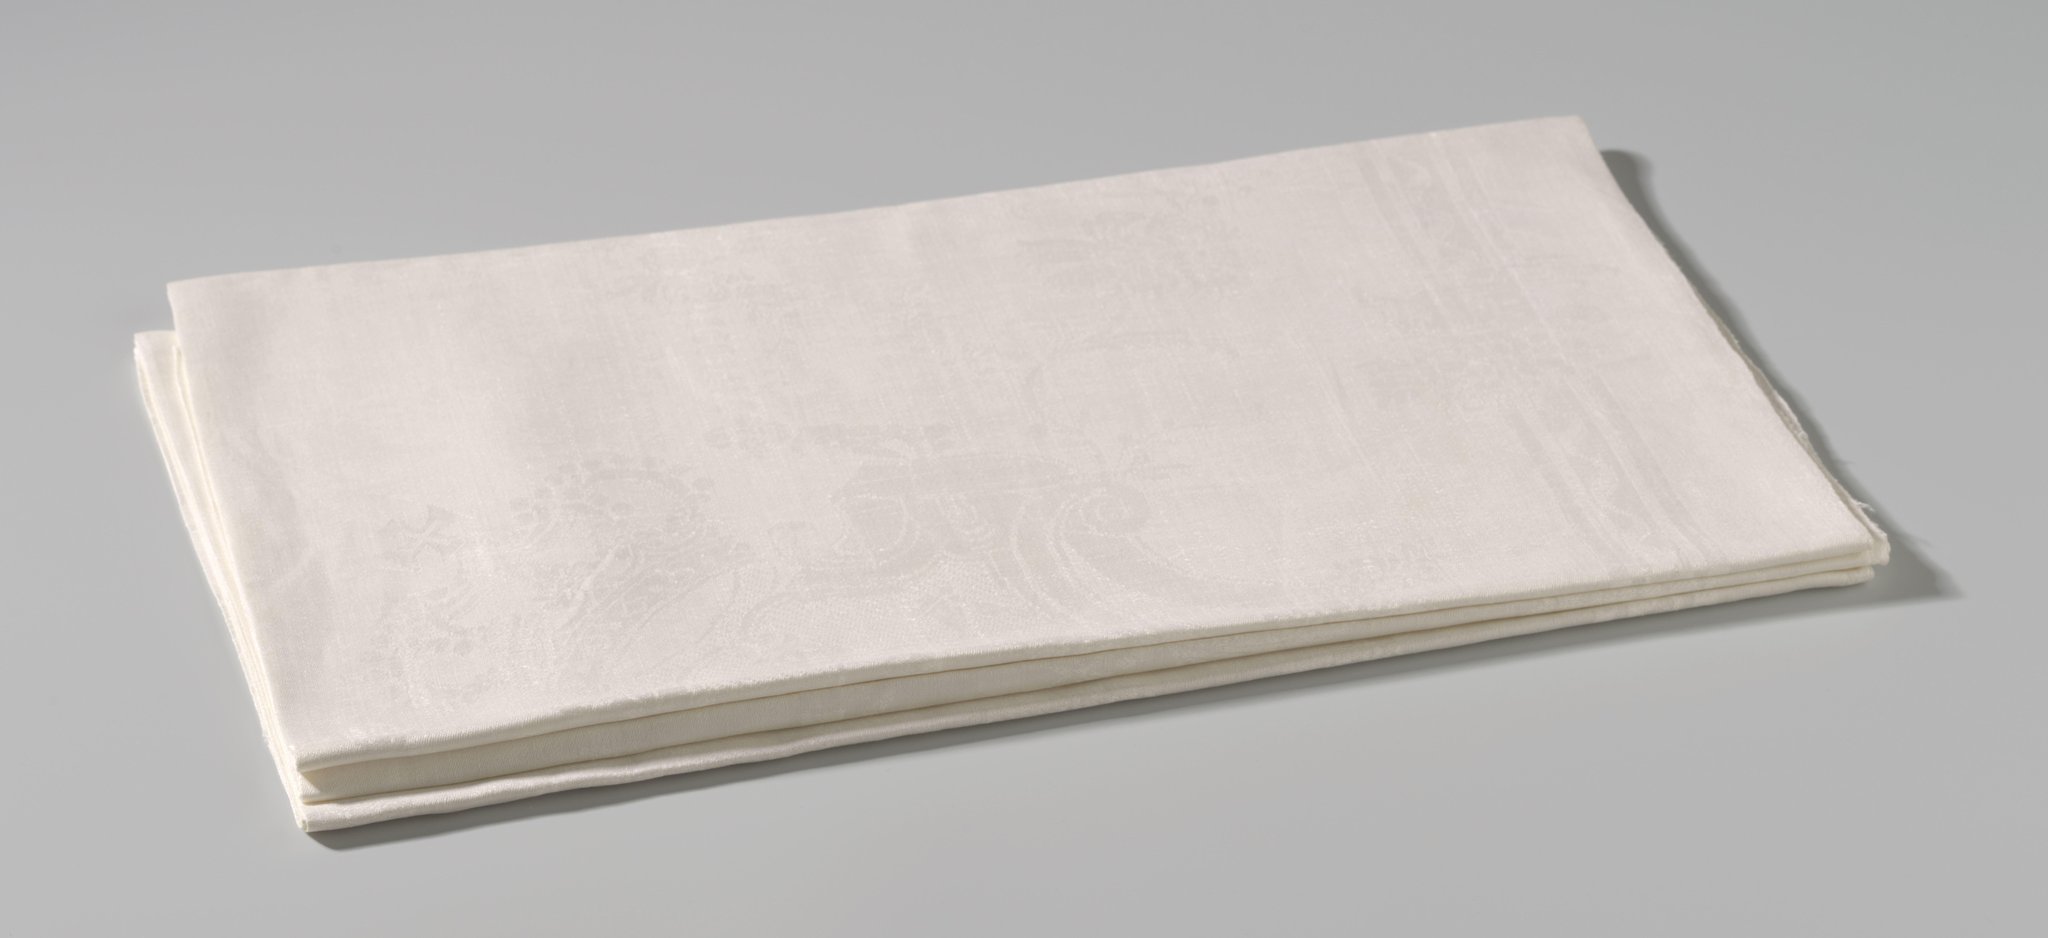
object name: tablecloth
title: Tafellaken met vijf wapens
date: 1700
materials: linen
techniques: damask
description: Tafellaken van linnendamast met vijf wapens, waarvan één in het midden en vier in de hoeken. Bloemenrand.